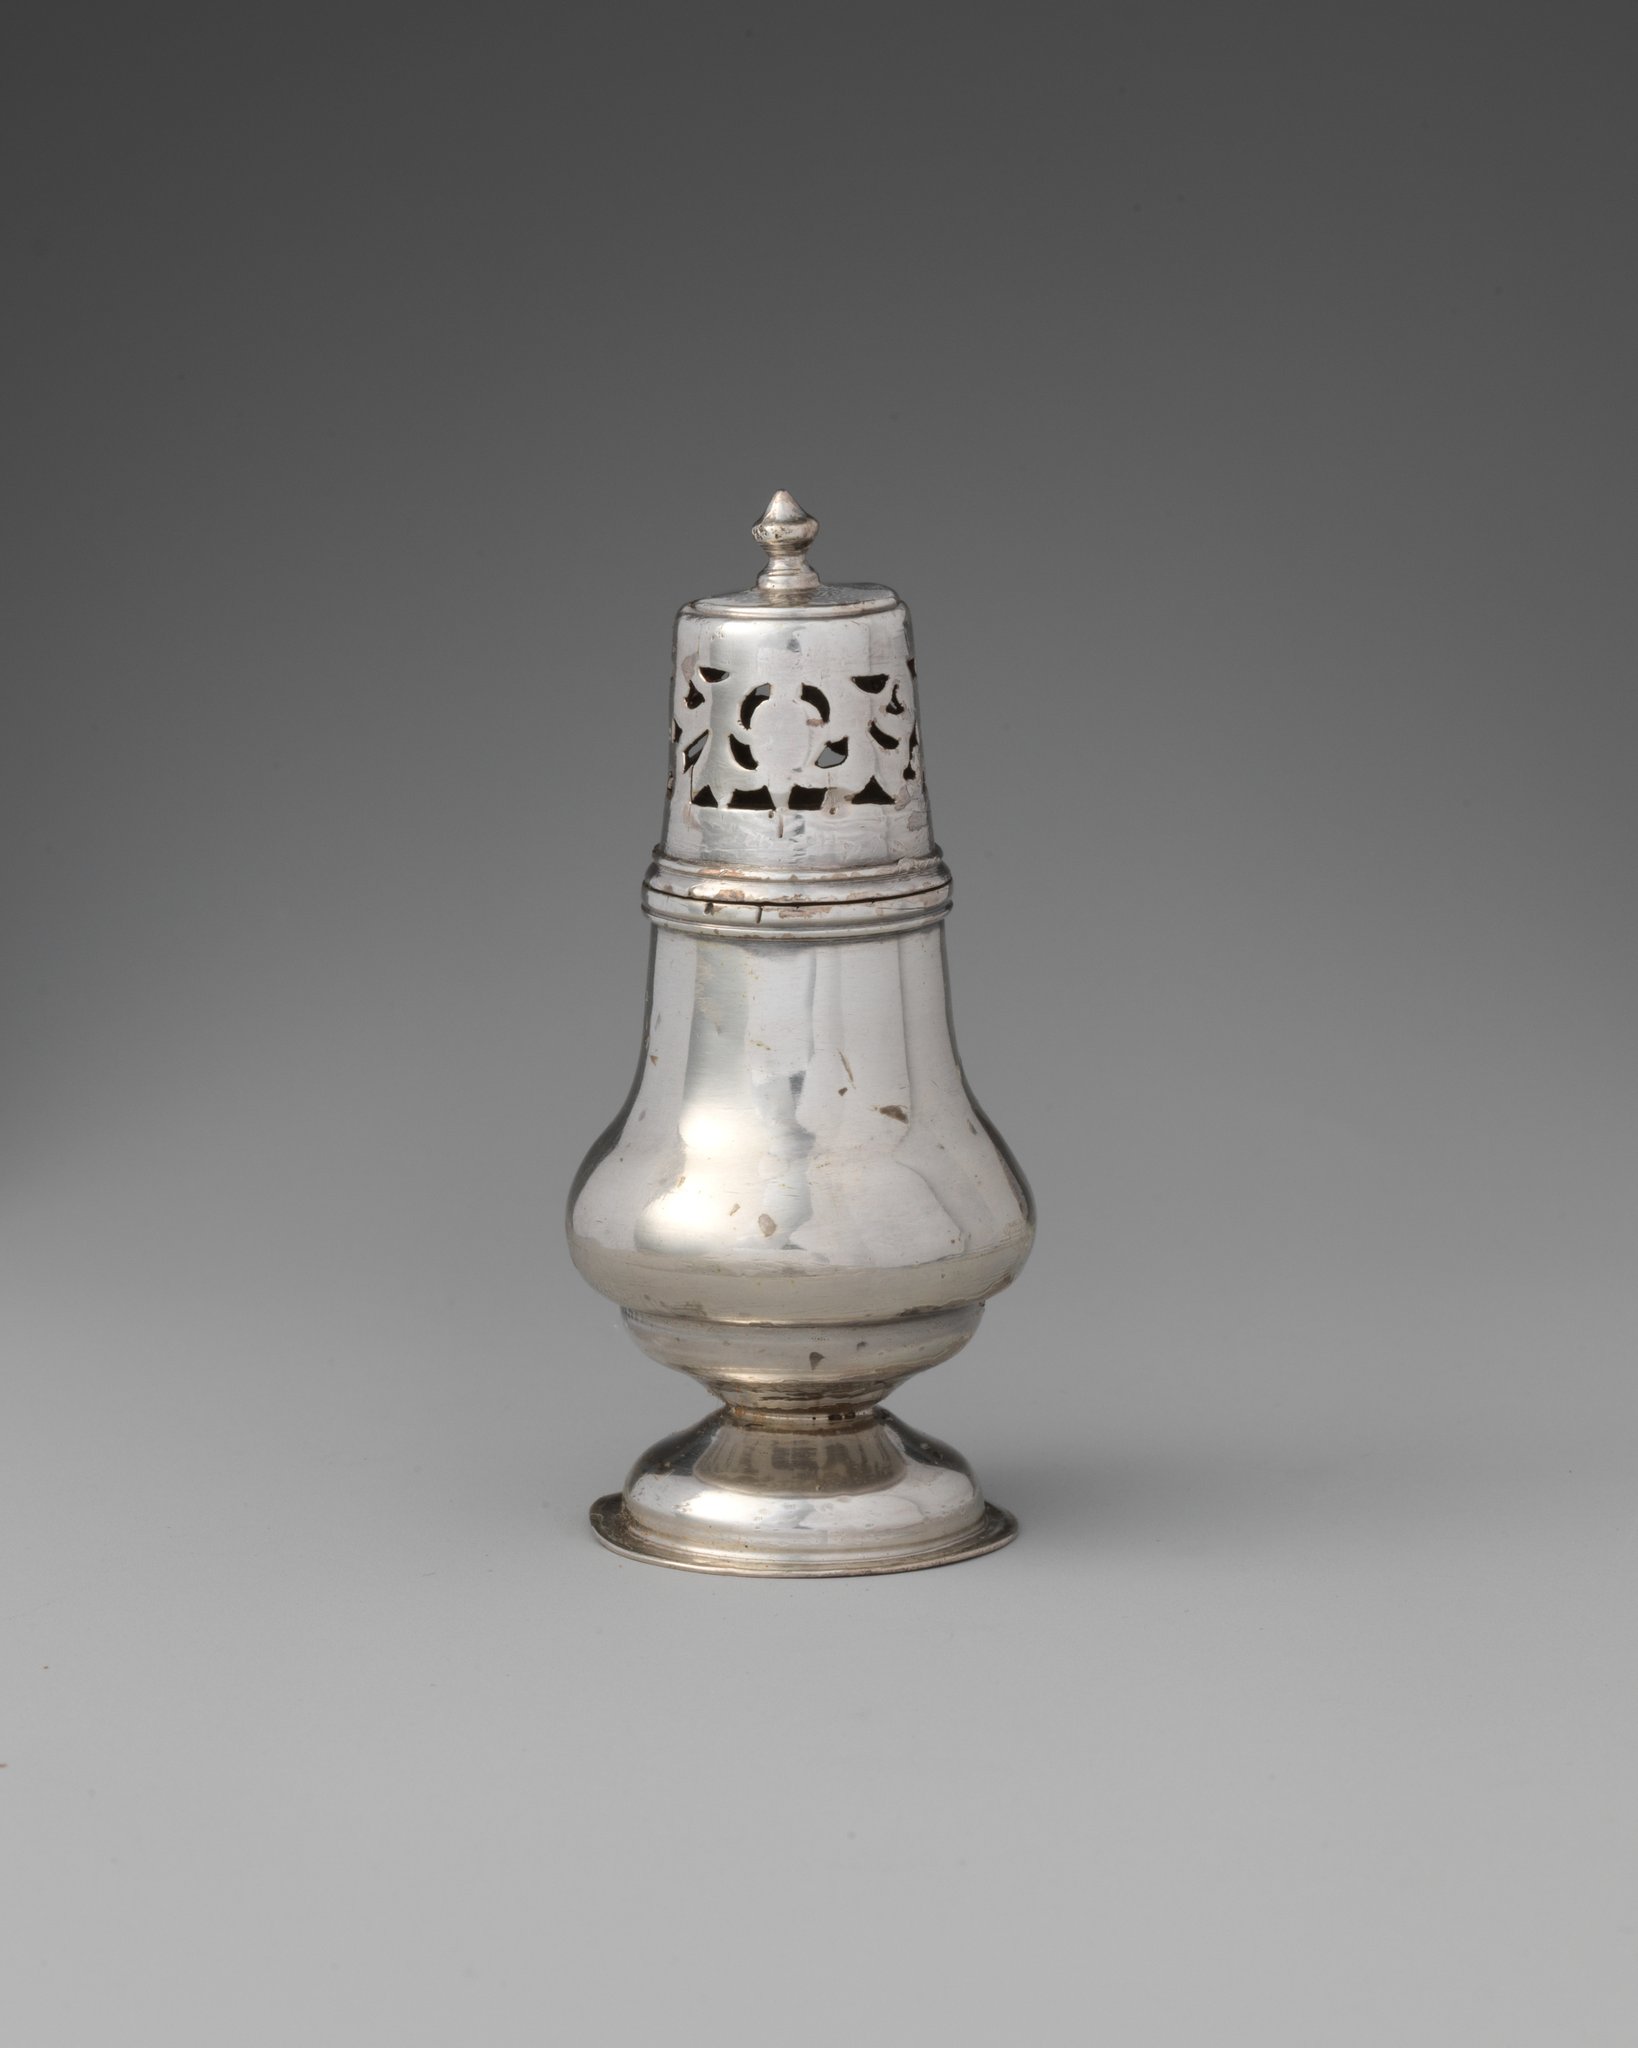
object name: cruet with cover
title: Miniature cruet with cover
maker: s. a.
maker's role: maker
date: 1738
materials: silver